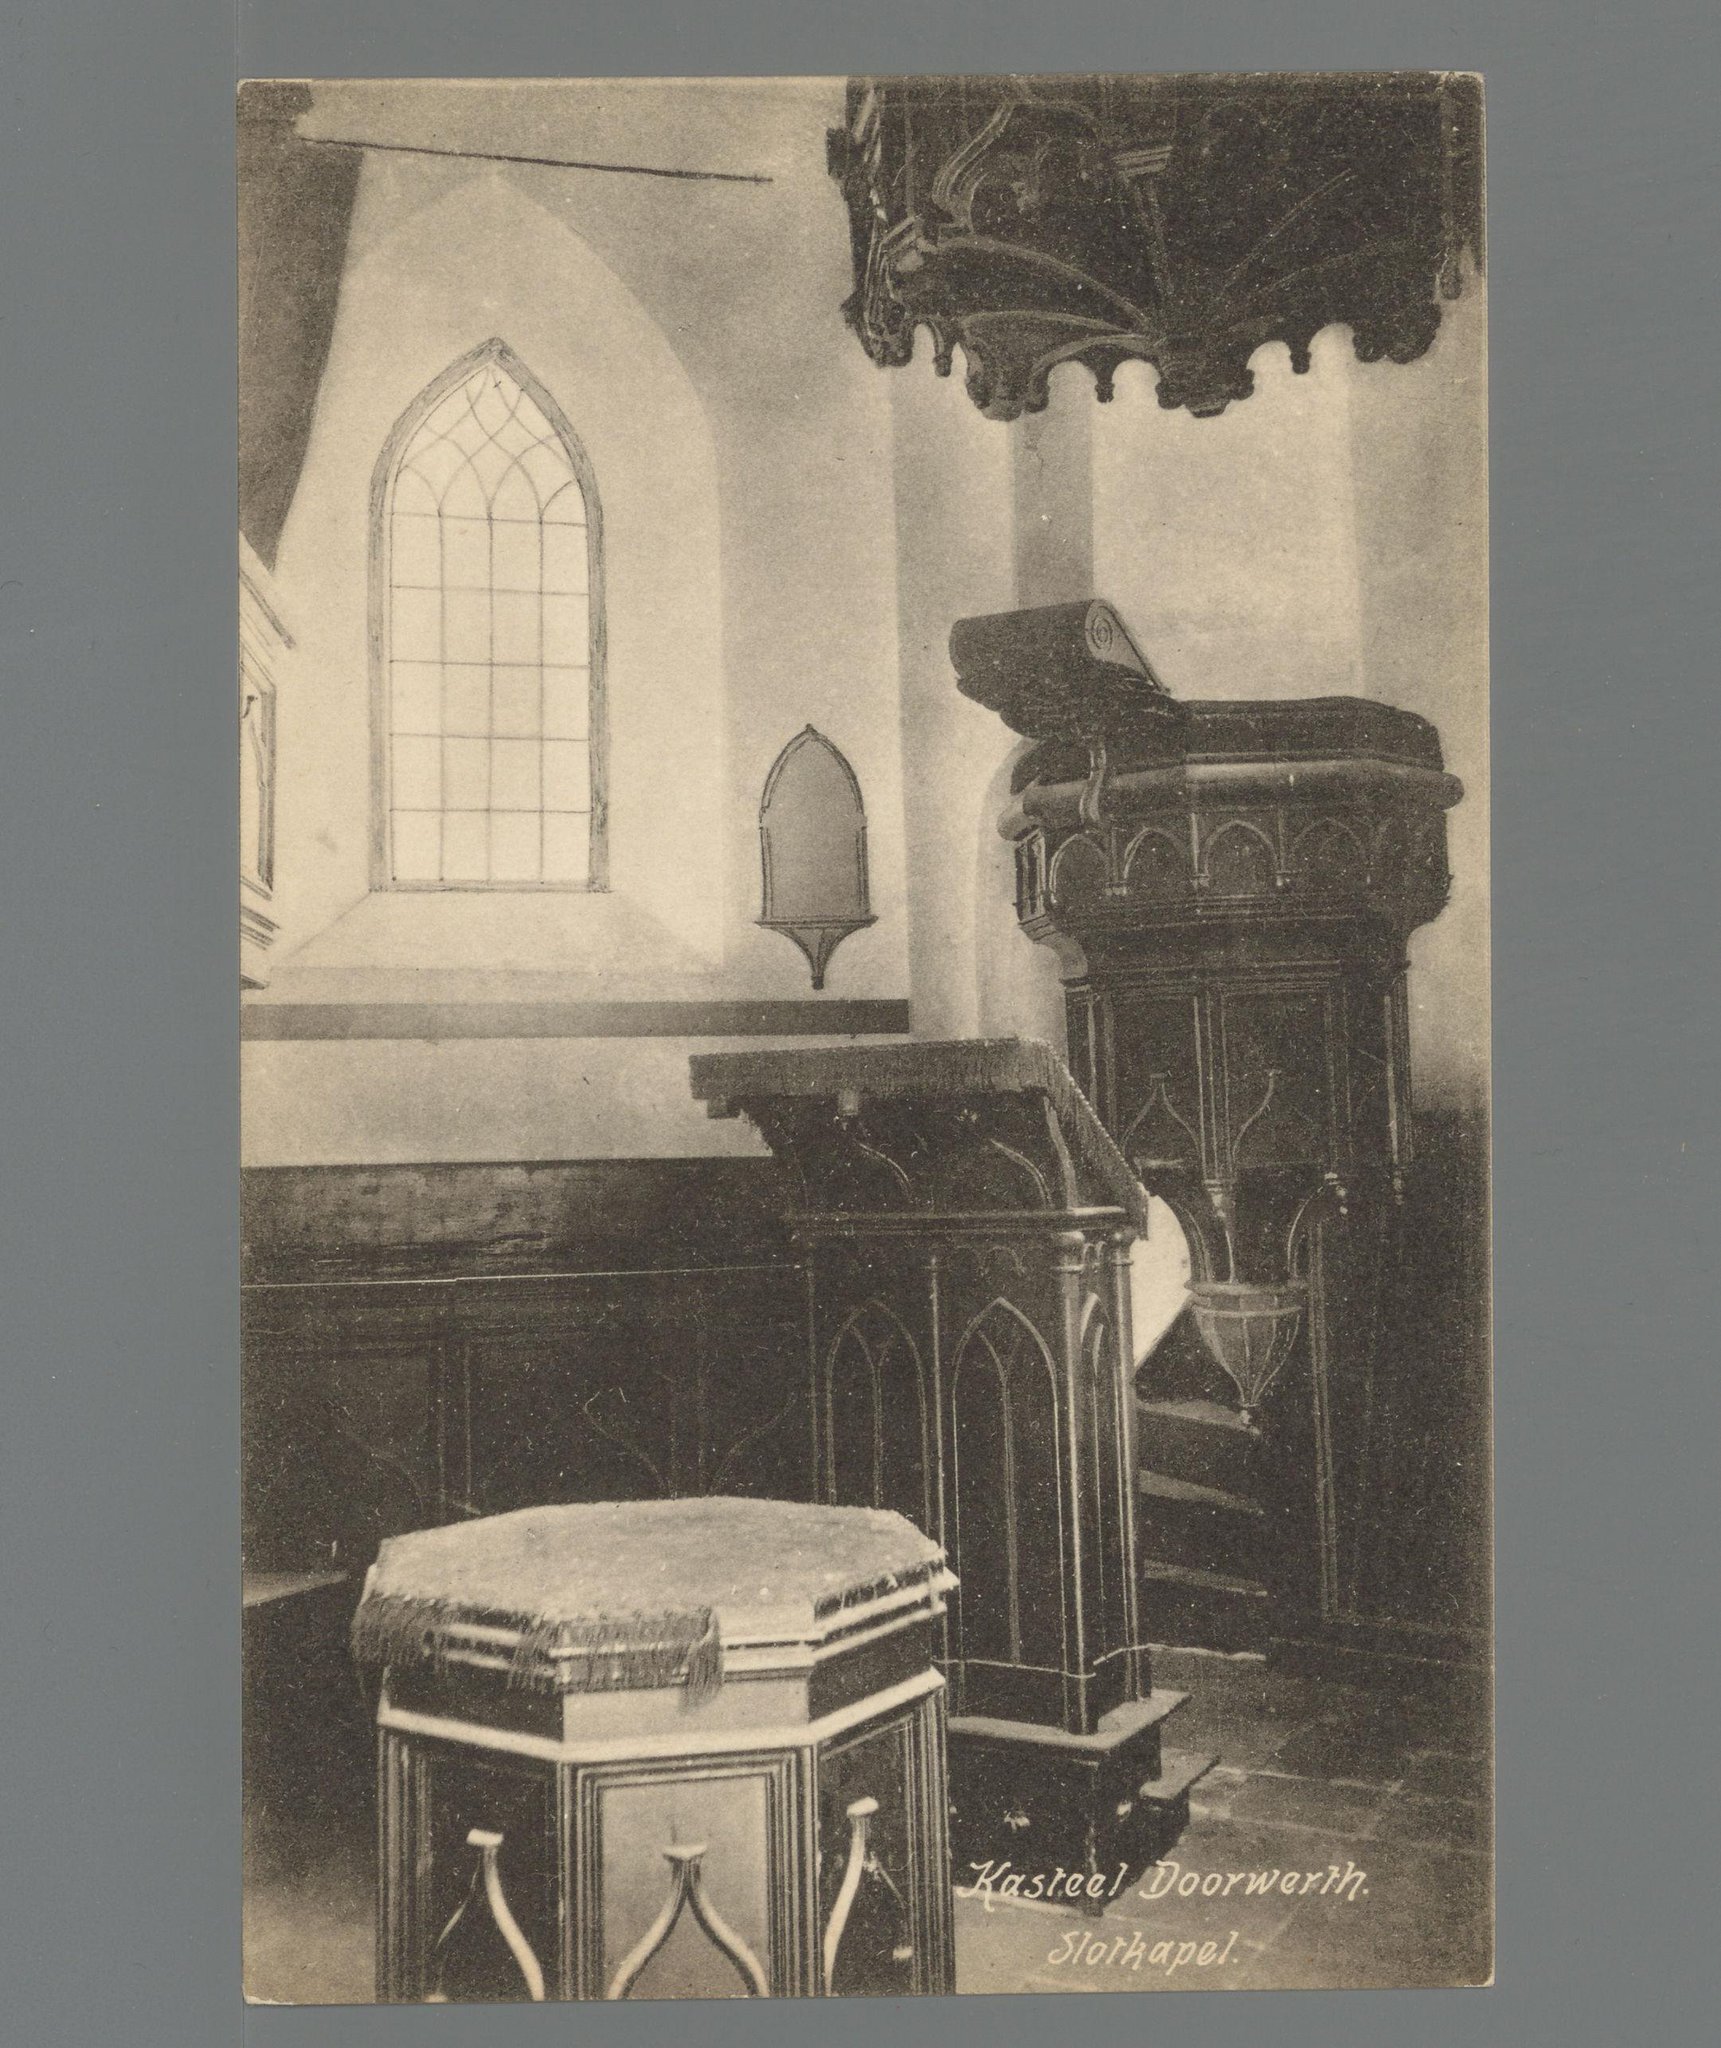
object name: ansichtkaart, prentbriefkaart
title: Kasteel Doorwerth. Slotkapel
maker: Anonymous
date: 1916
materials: cardboard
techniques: photograph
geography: the hague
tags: castle, pulpit, ambo, chancel, parts of church interior: chapel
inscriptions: date